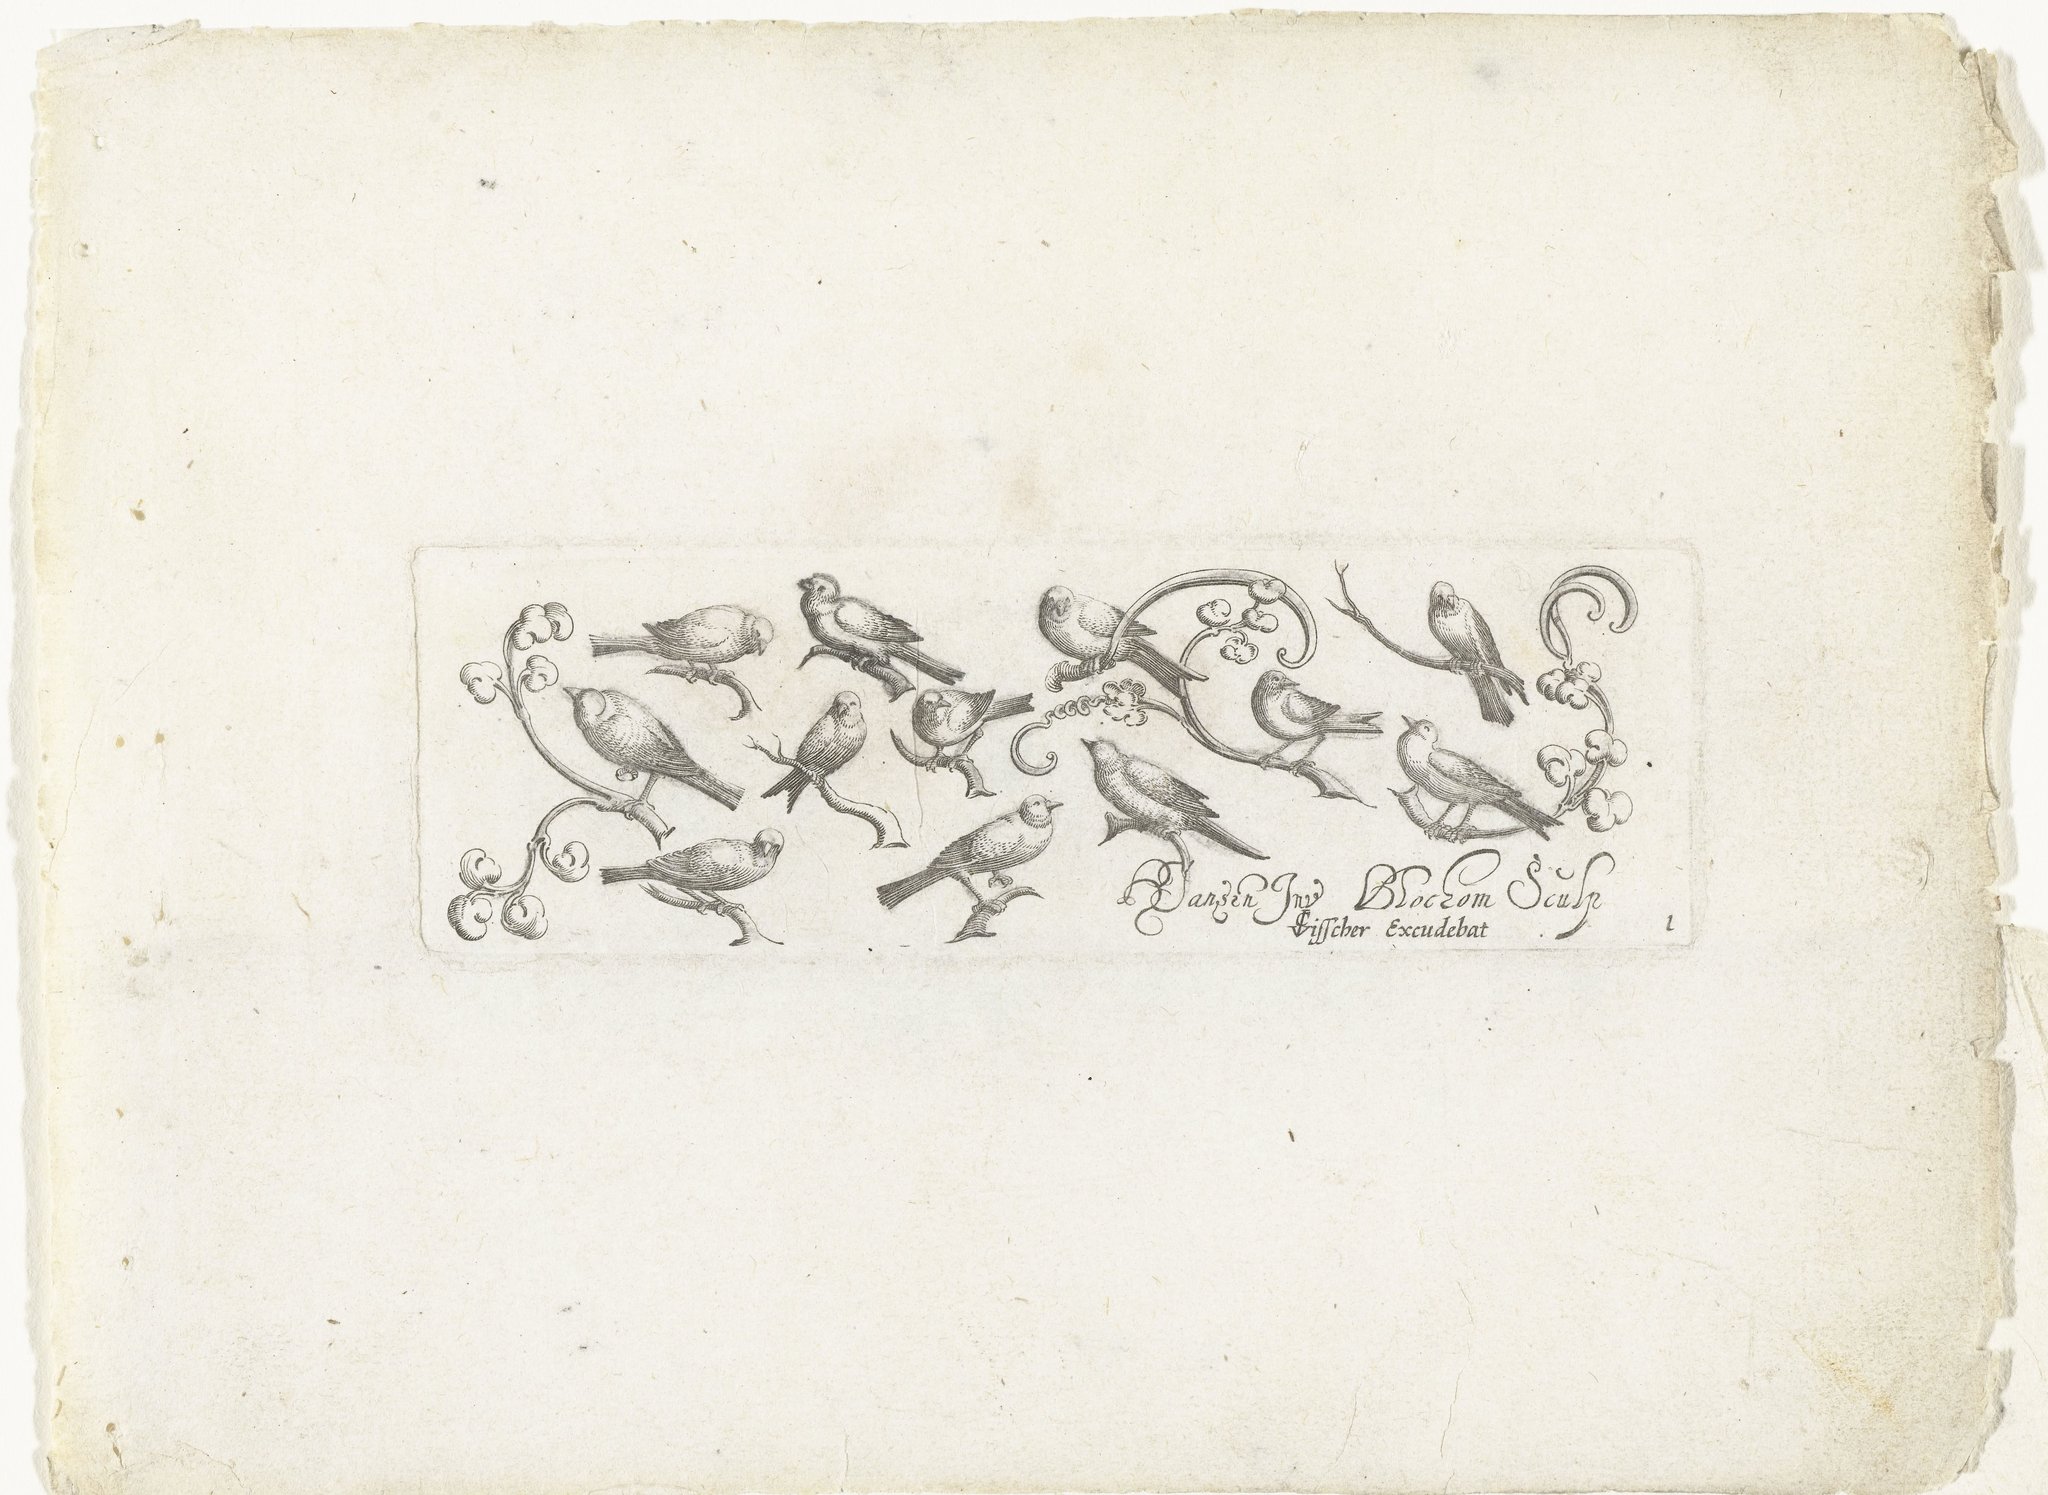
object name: print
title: Twaalf vogels op takken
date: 1630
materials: paper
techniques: engraving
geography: amsterdam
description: De takken lopen gedeeltelijk uit in ranken.